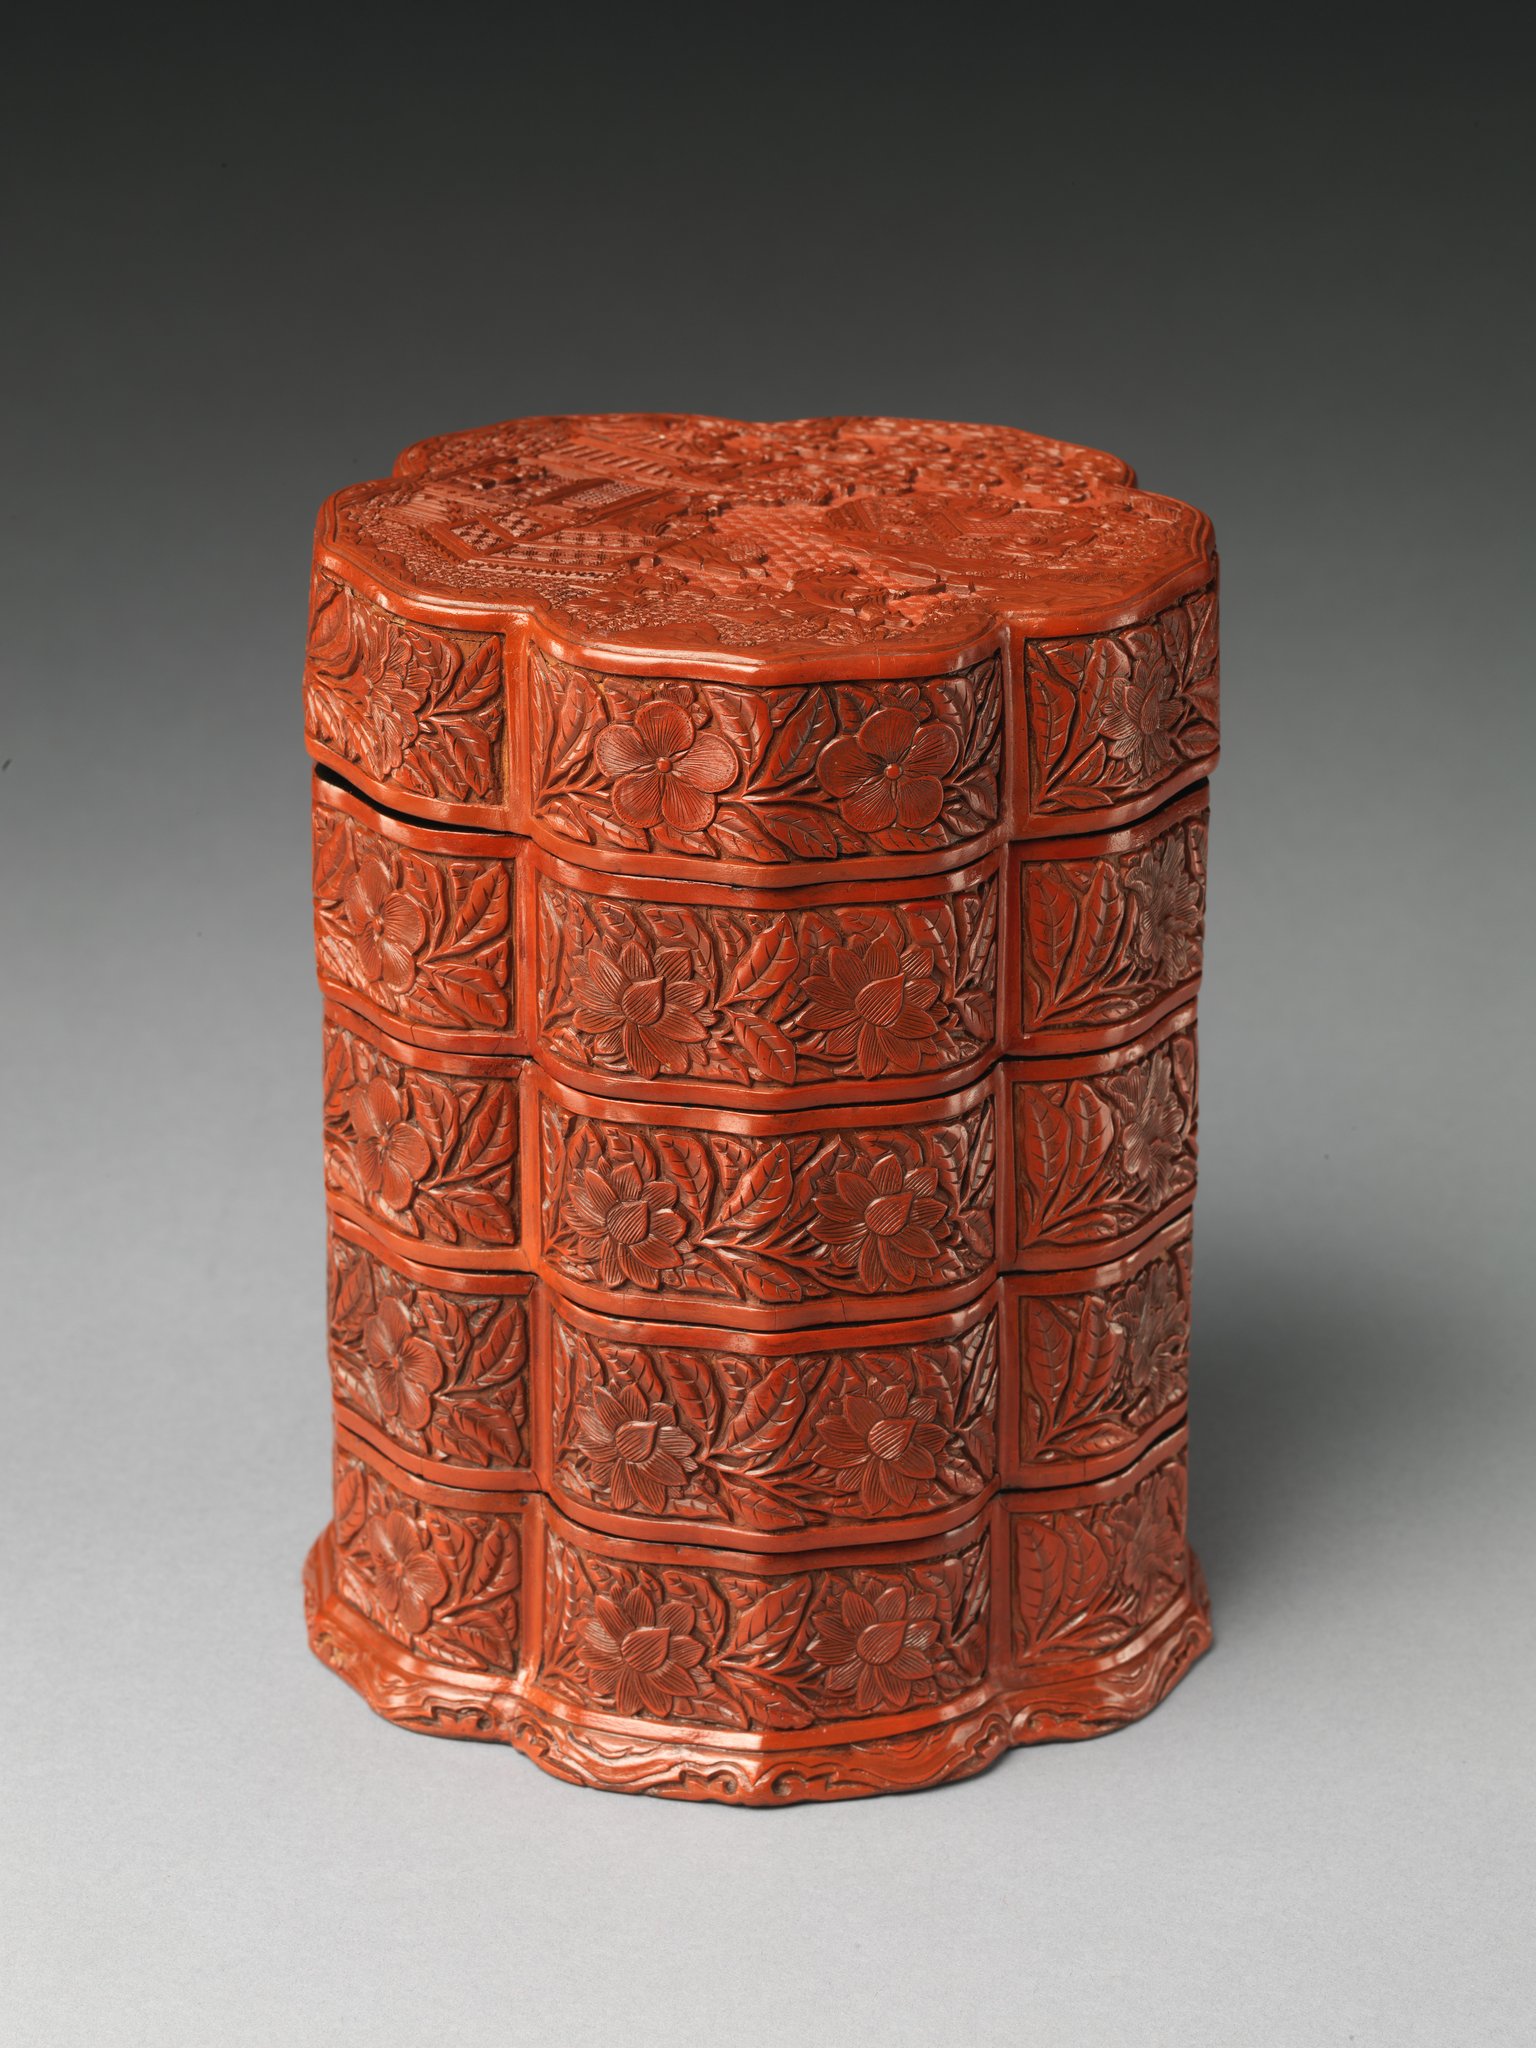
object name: four tiered box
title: Four-tiered box with scholars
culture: chinese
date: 1701-1800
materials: lacquer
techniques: carving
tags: flowers,leaves